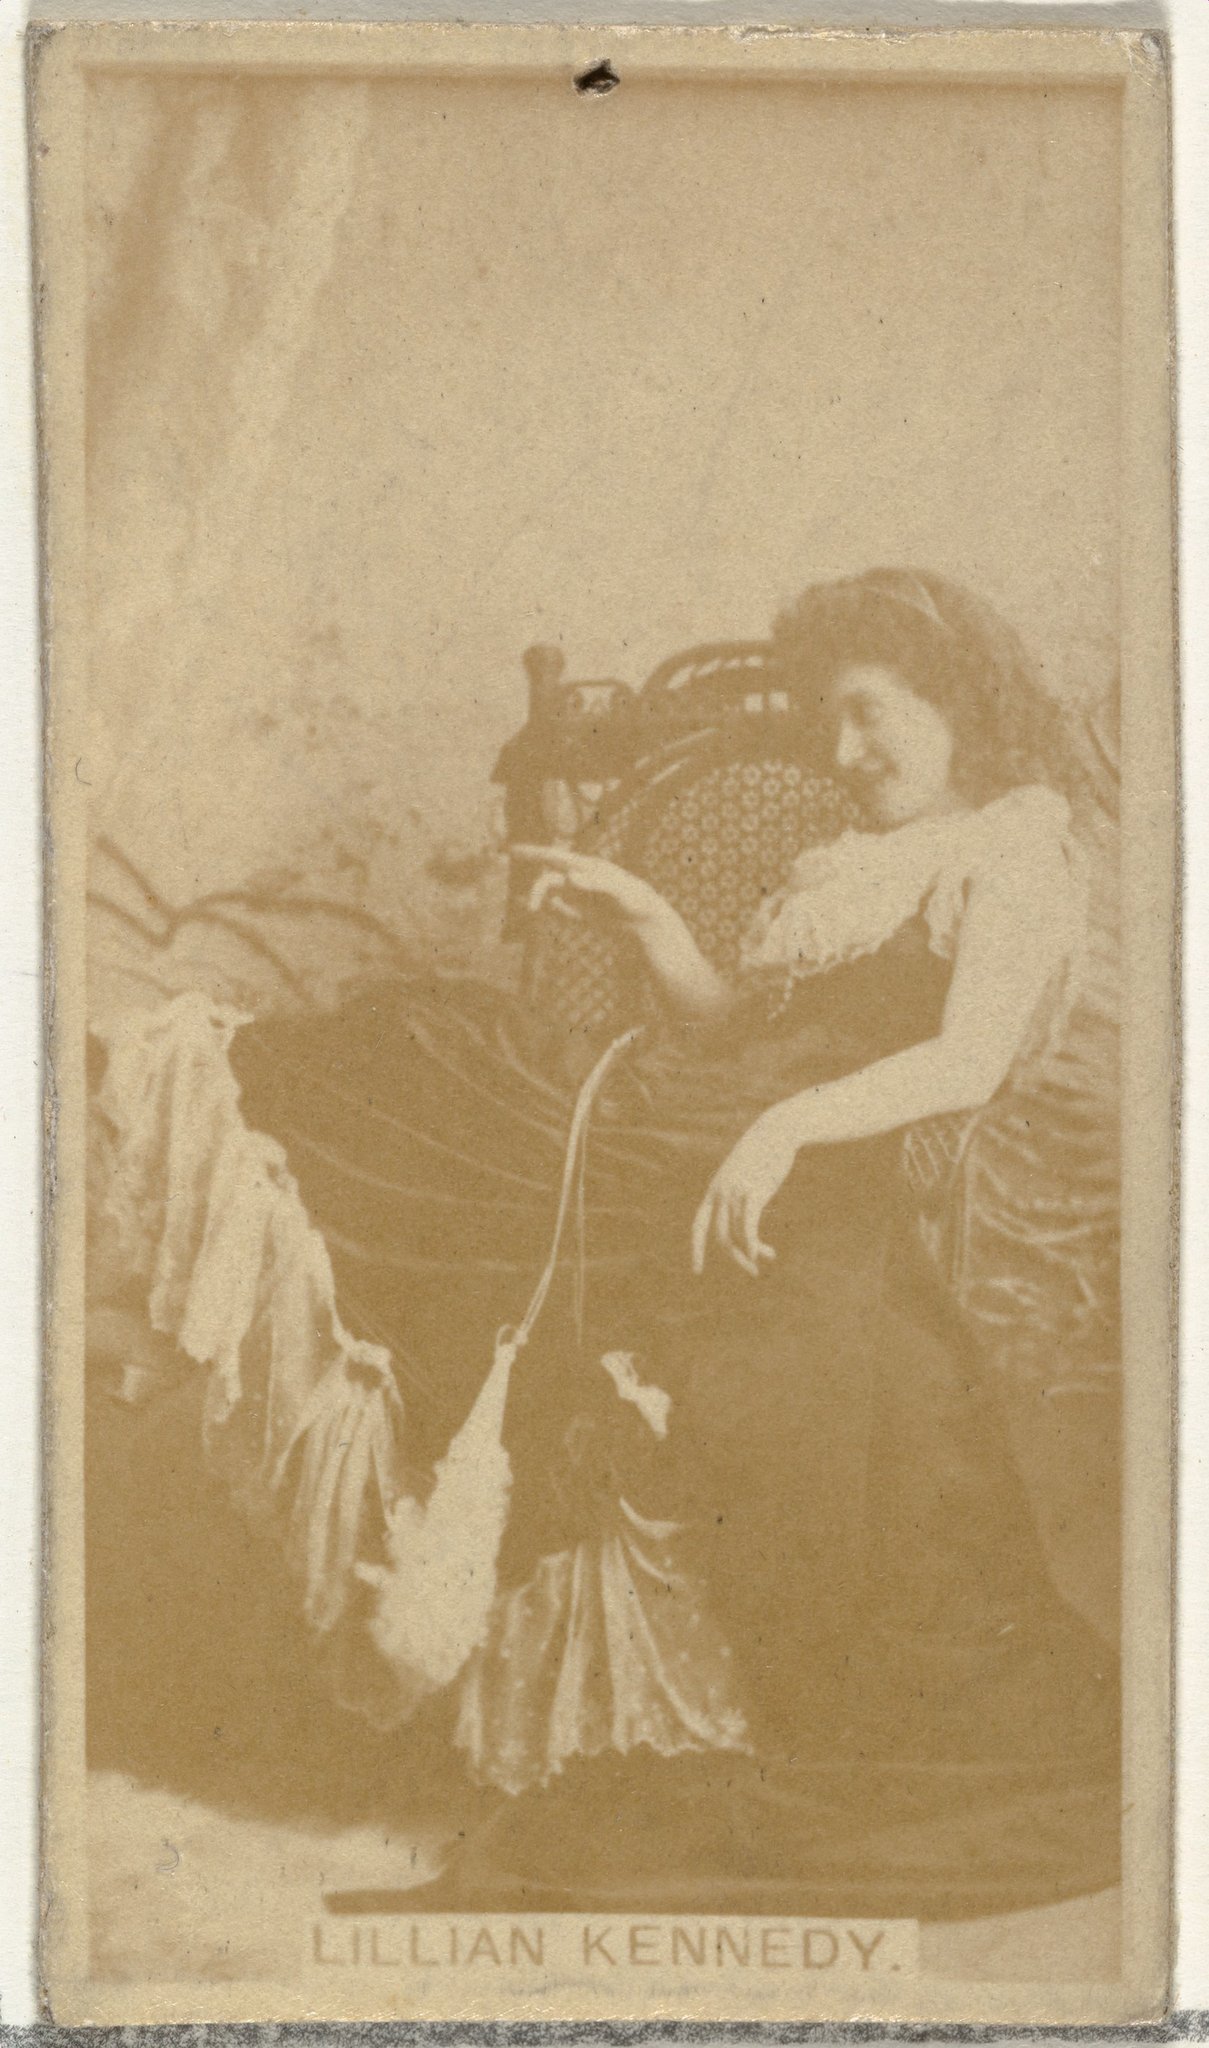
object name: photograph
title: Lillian Kennedy, from the Actors and Actresses series (N145-8) issued by Duke Sons & Co. to promote Duke Cigarettes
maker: w. duke, sons & co.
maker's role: publisher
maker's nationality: american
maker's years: 1870-1920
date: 1891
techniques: albumen silver print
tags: portraits,women,actresses